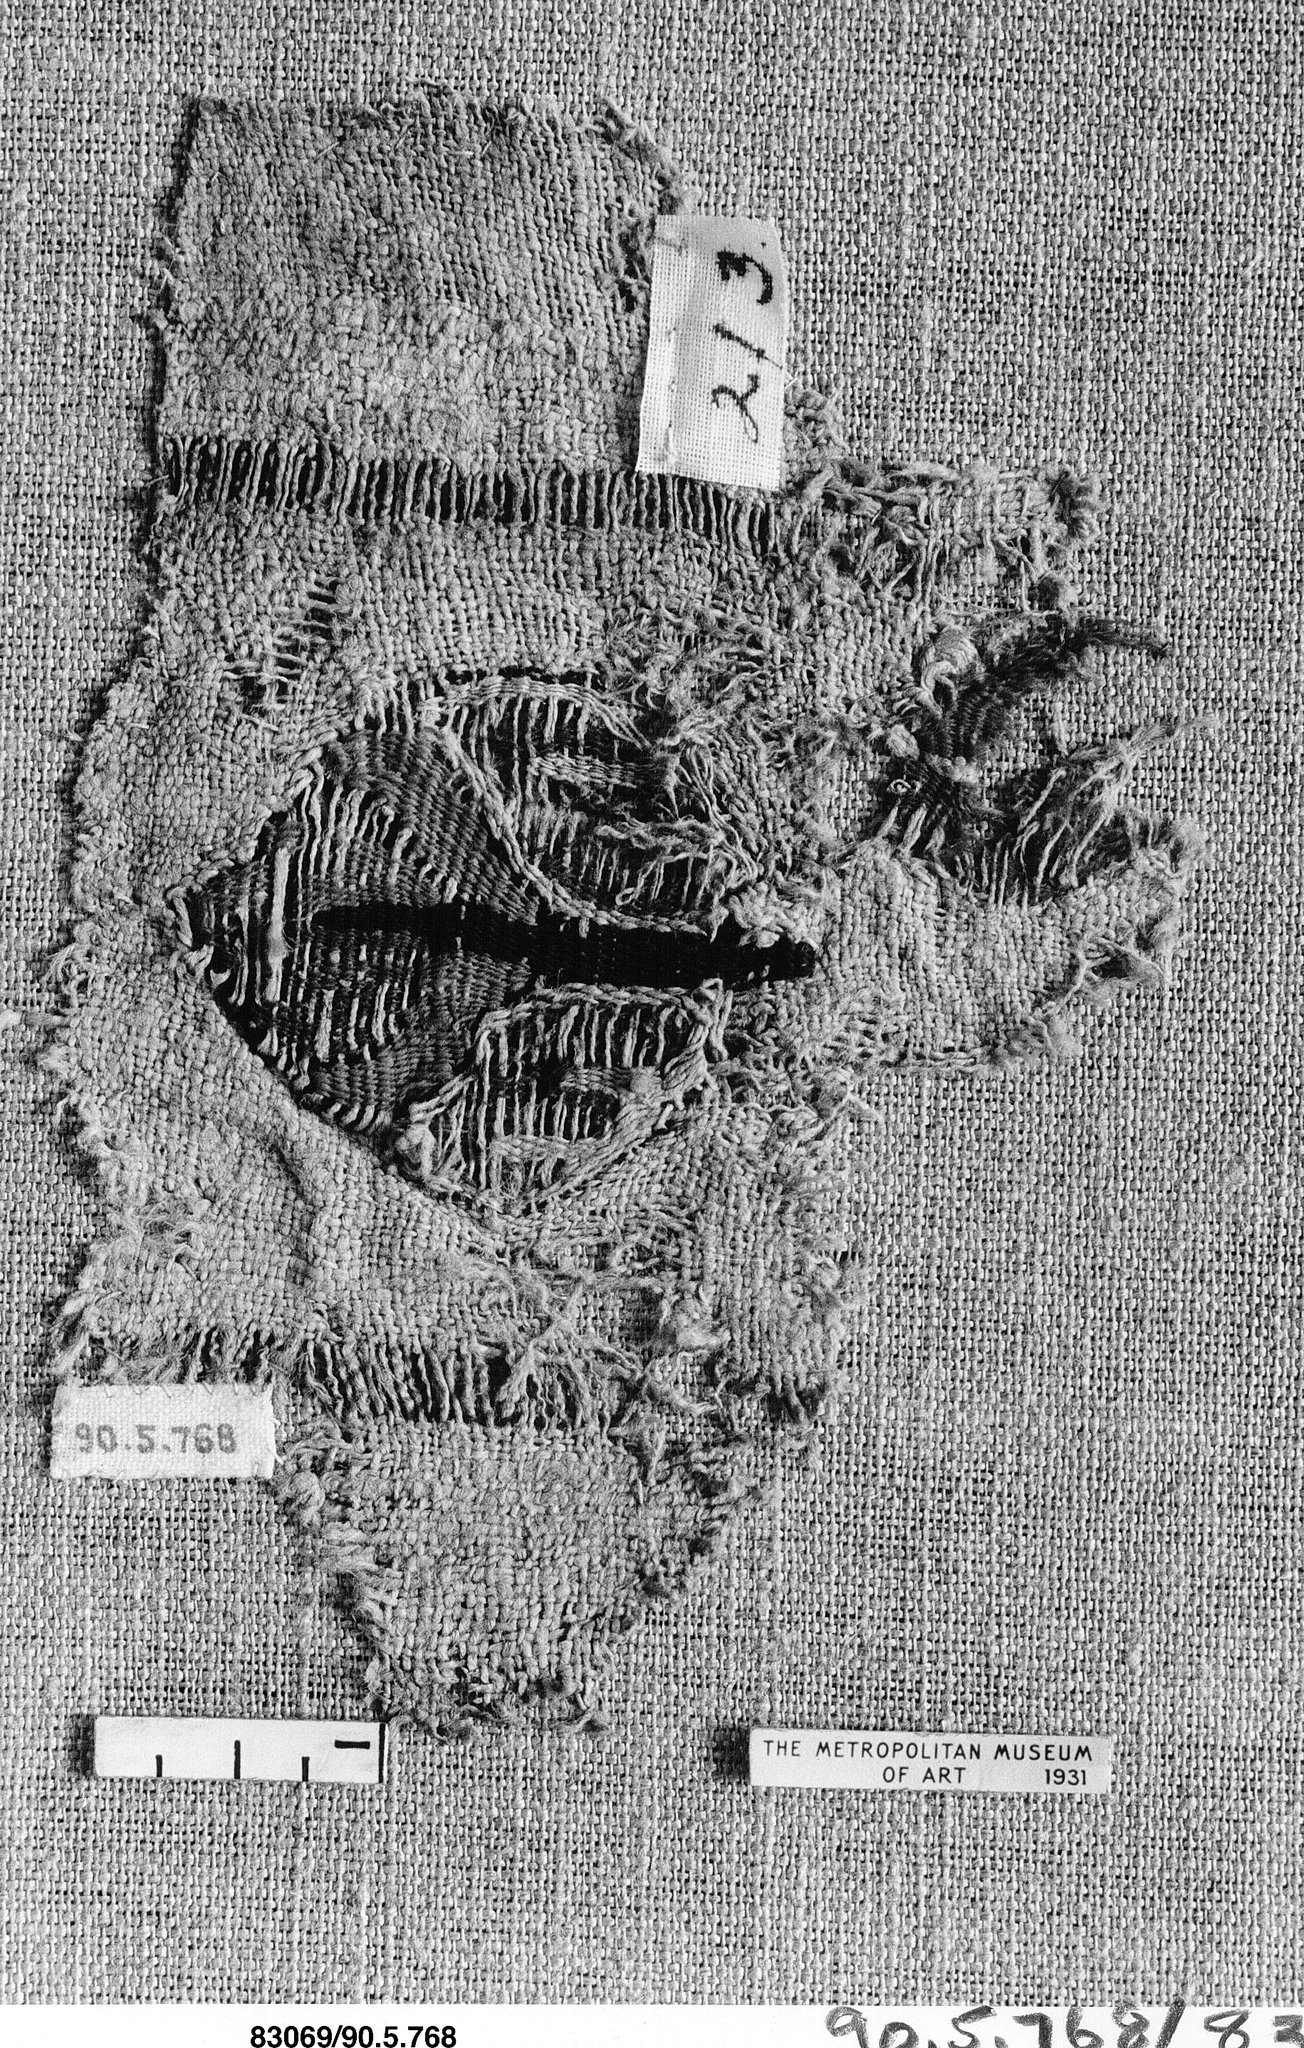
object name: textile fragment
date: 401-600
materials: linen, wool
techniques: weave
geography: egypt